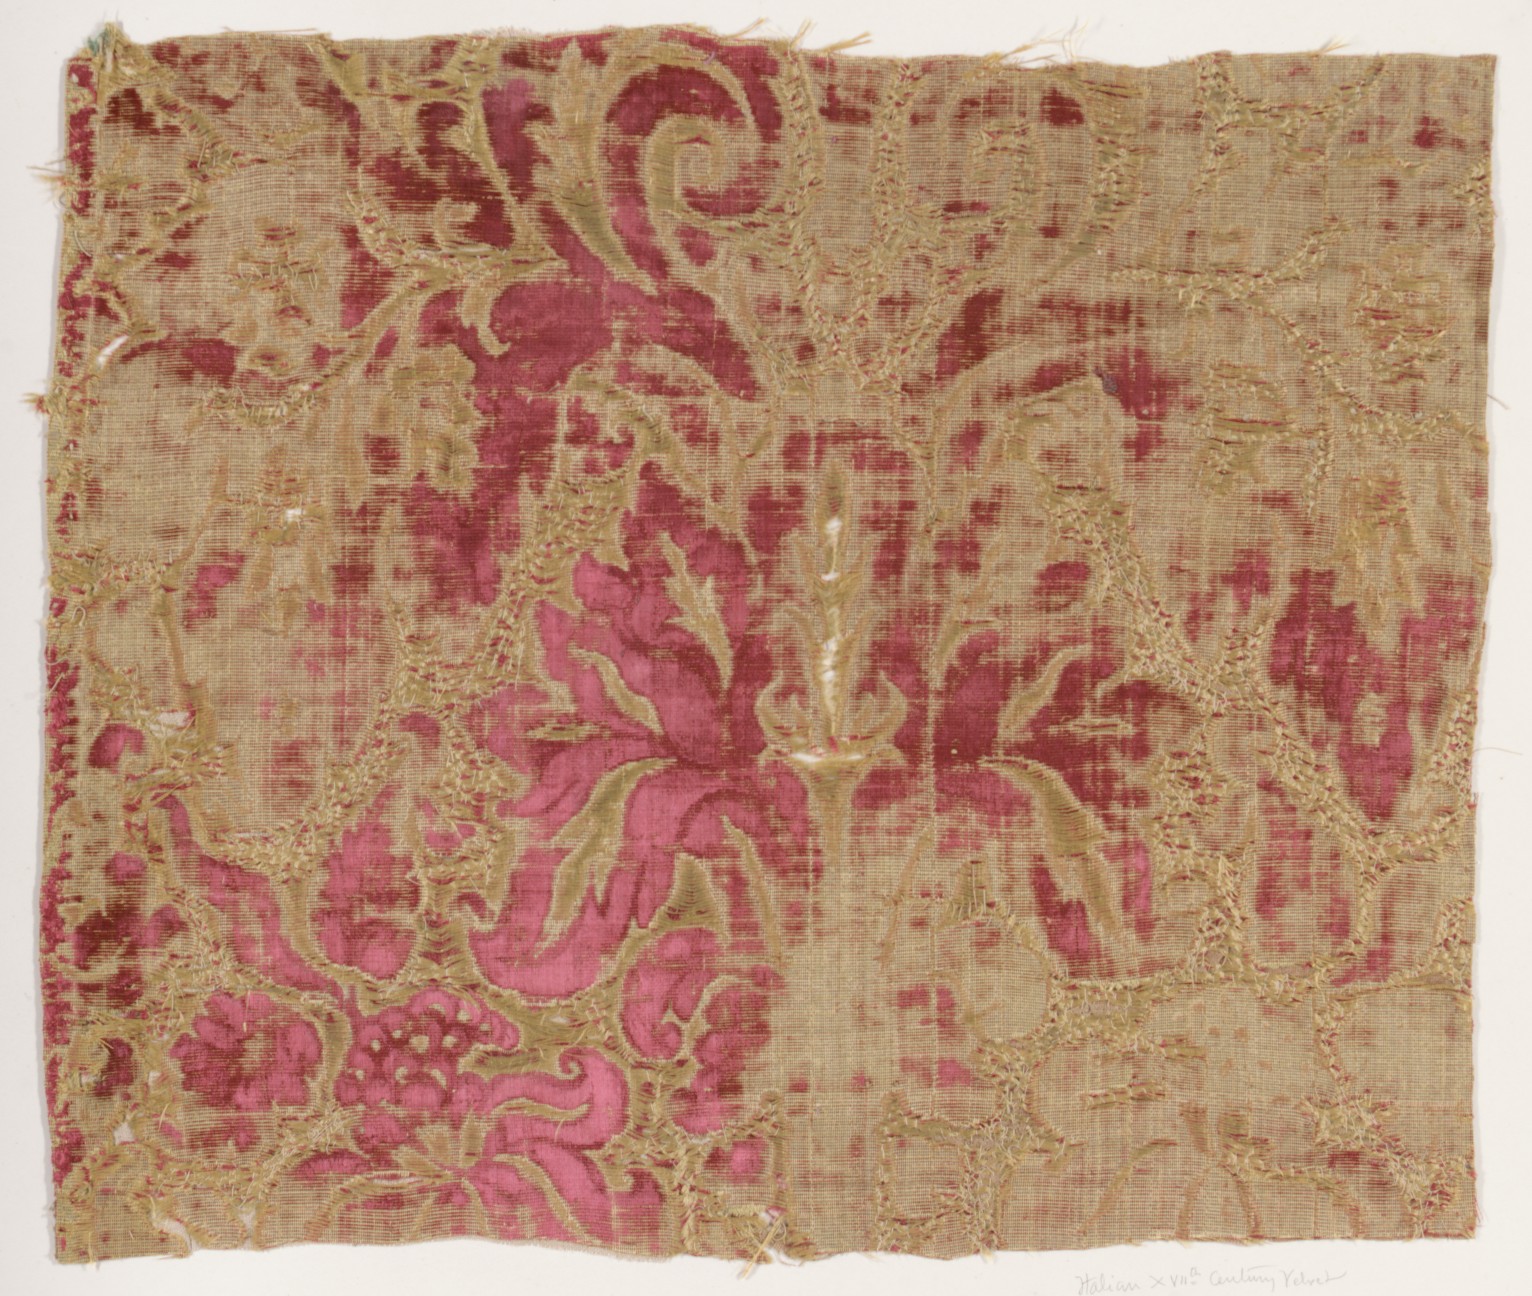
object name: fragment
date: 1601-1700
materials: silk